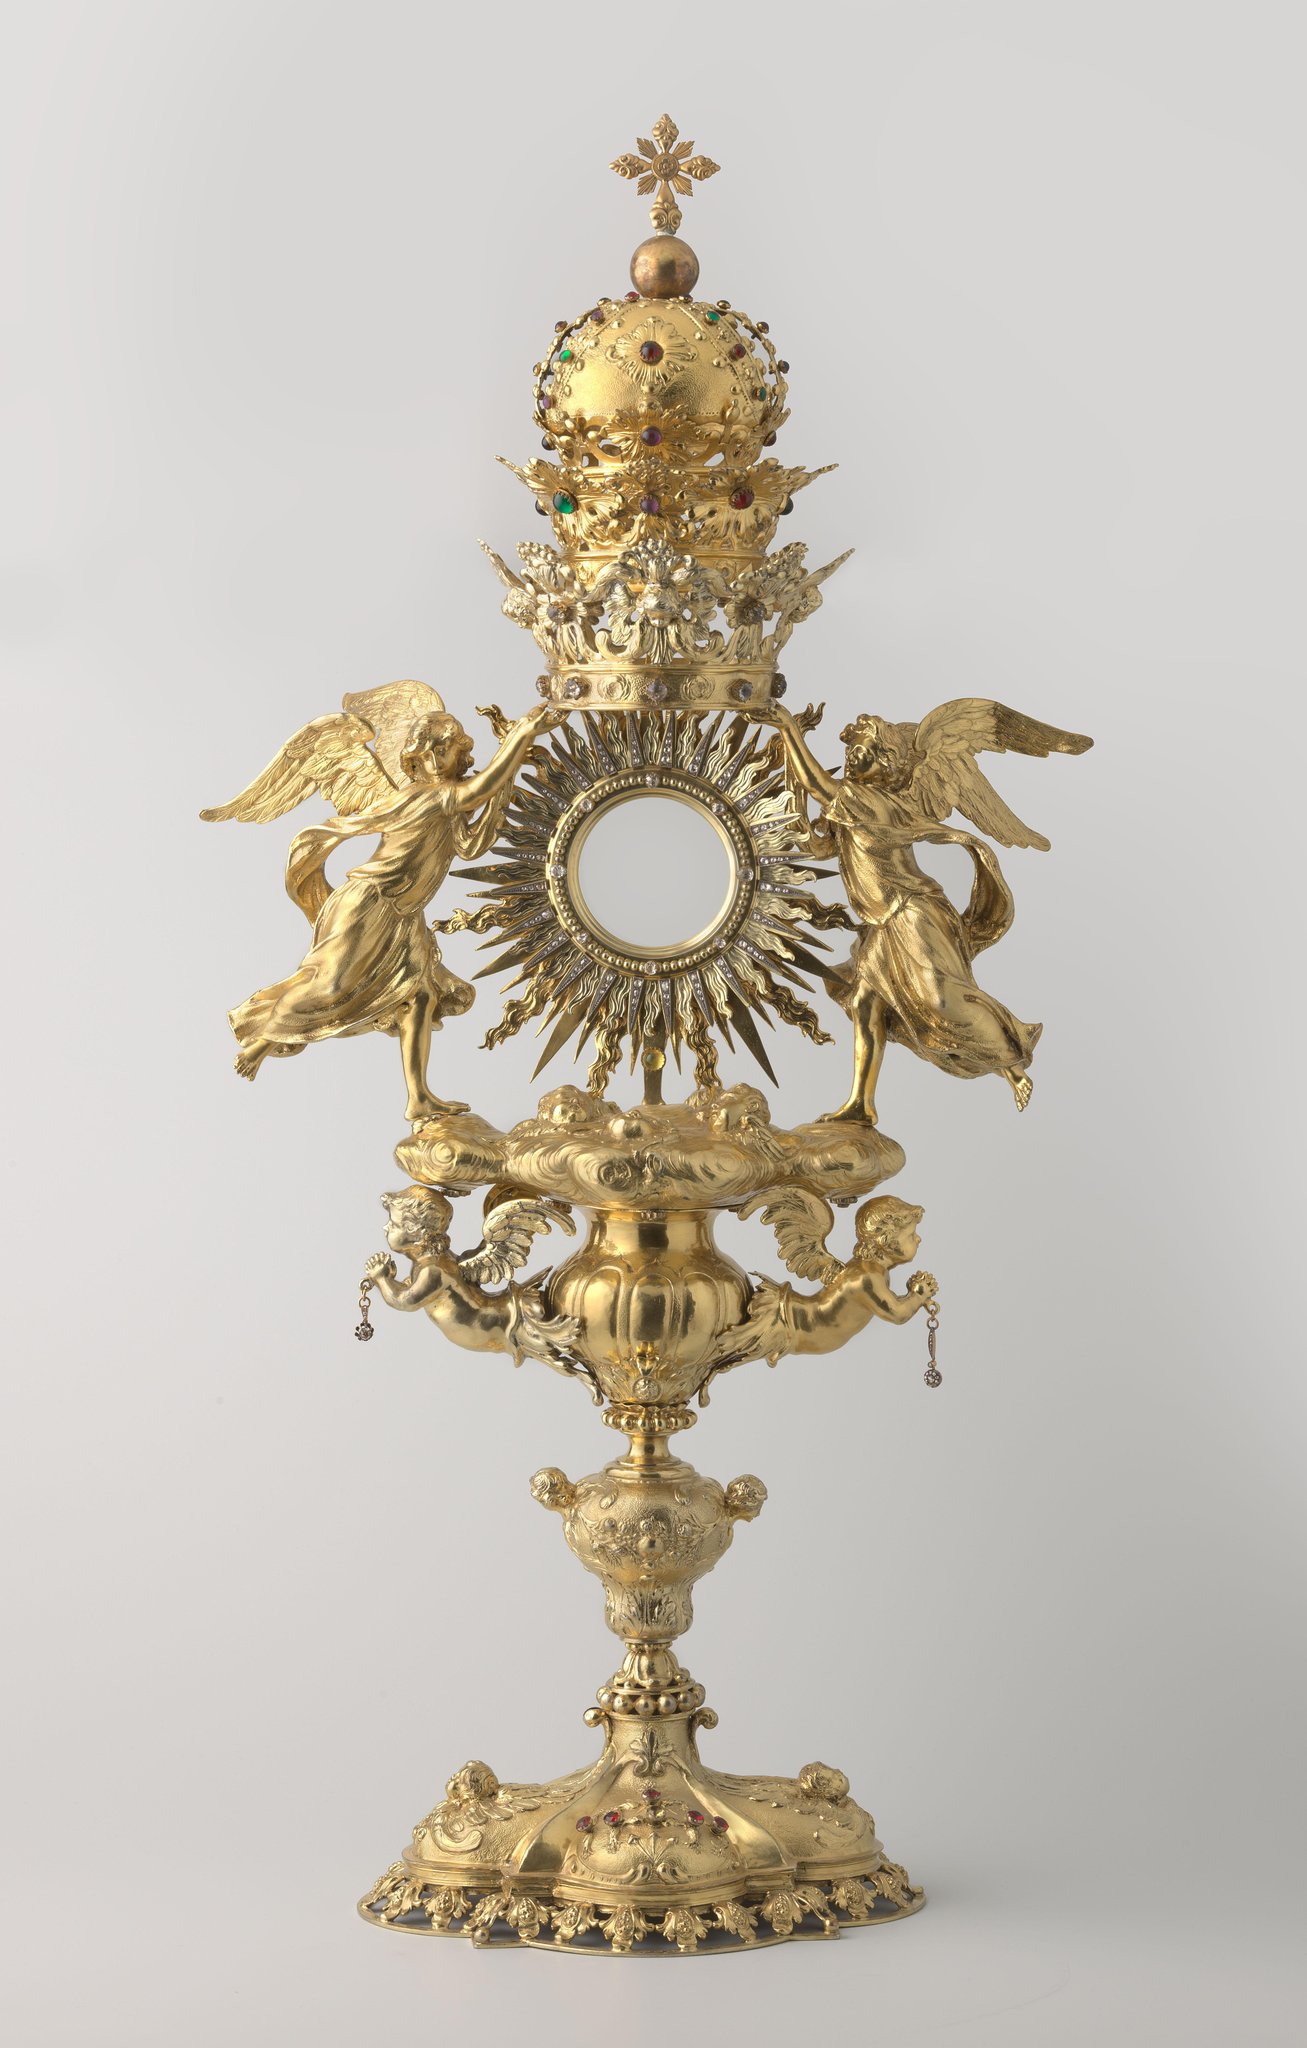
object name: monstrans, ostensorium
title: Monstrans van verguld zilver met voorstelling van Het Laatste Avondmaal en monogram Christus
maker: jean moermans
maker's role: goldsmith, silversmith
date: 1655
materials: silver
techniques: gilding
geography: antwerp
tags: last supper (in general) (matthew 26:21-35; mark 14:18-31; luke 22:3, 22:15-23; john 13:21-38)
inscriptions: date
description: Monstrans van verguld zilver, versierd met engelenkopjes, het monogram van Christus en een voorstelling van het Laatste Avondmaal. Op de kroon niet bijbehorende wereldbol met kruis. Op de hostiehouder is een stralenkrans met diamanten gemonteerd.